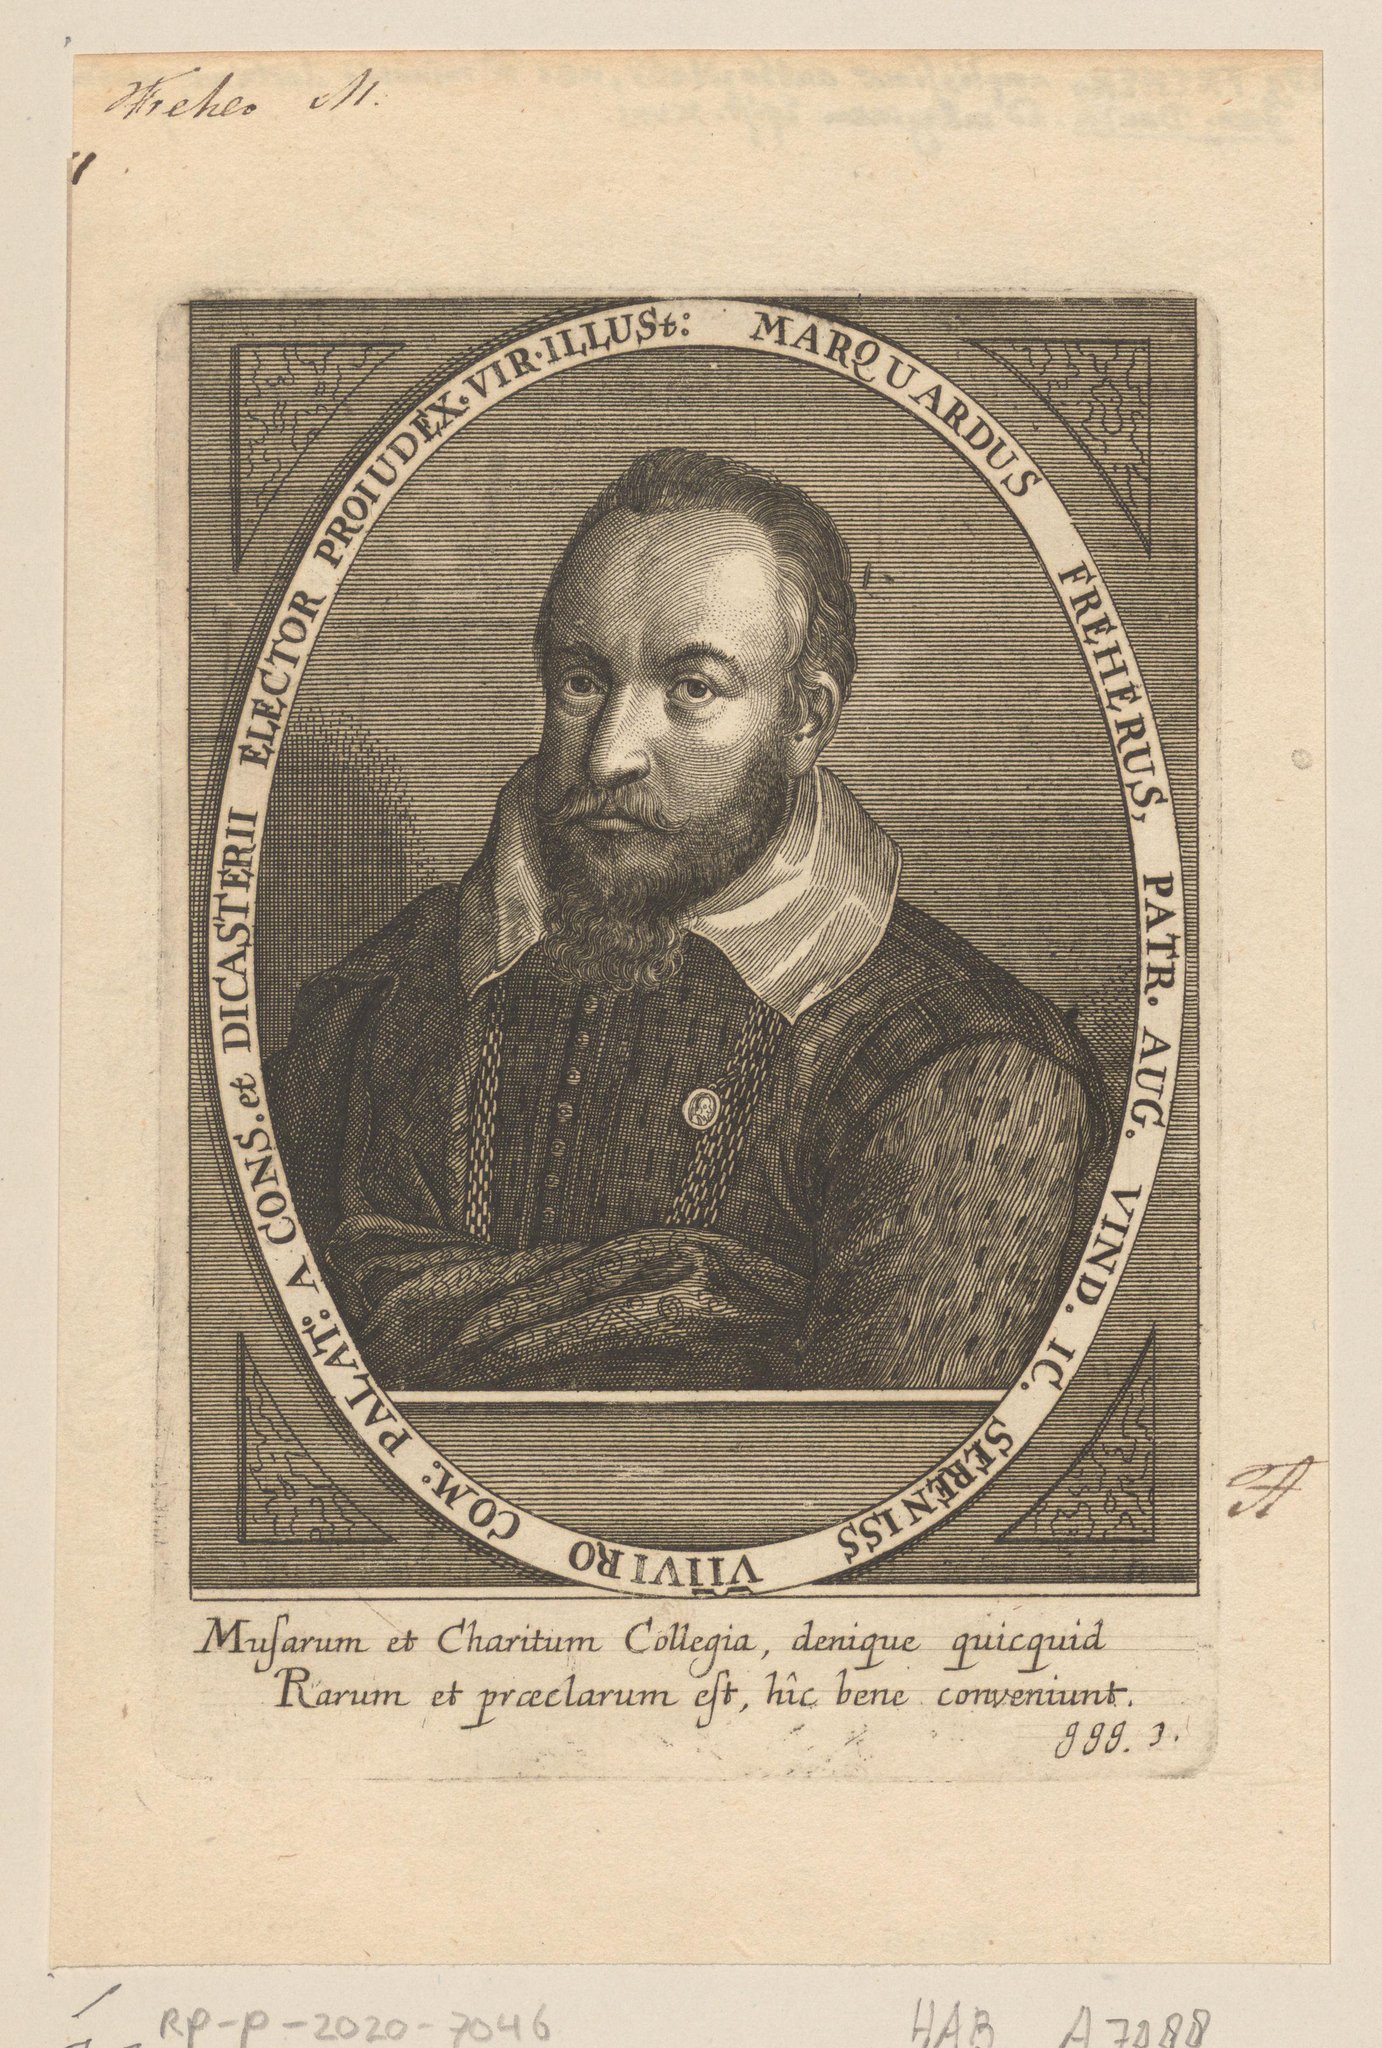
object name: print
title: Portret van Marquard Freher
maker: clemens ammon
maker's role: print maker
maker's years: 1627-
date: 1650-1652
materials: paper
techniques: engraving, etching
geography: germany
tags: augsburg, historical persons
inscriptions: inscription: ‘[R?]Dg FREHER, amplissima authoritatis, nec n minoris doctrinas, quam/ Jan. Dousa, ad marginem Epist. XVIII.’, inscription: ‘Freher M’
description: Prent waarschijnlijk uit een deel van: Boissard, Jean Jacques. Bibliotheca chalcographica (...). Frankfurt am Main: Johannes Ammon, 1650-1652.